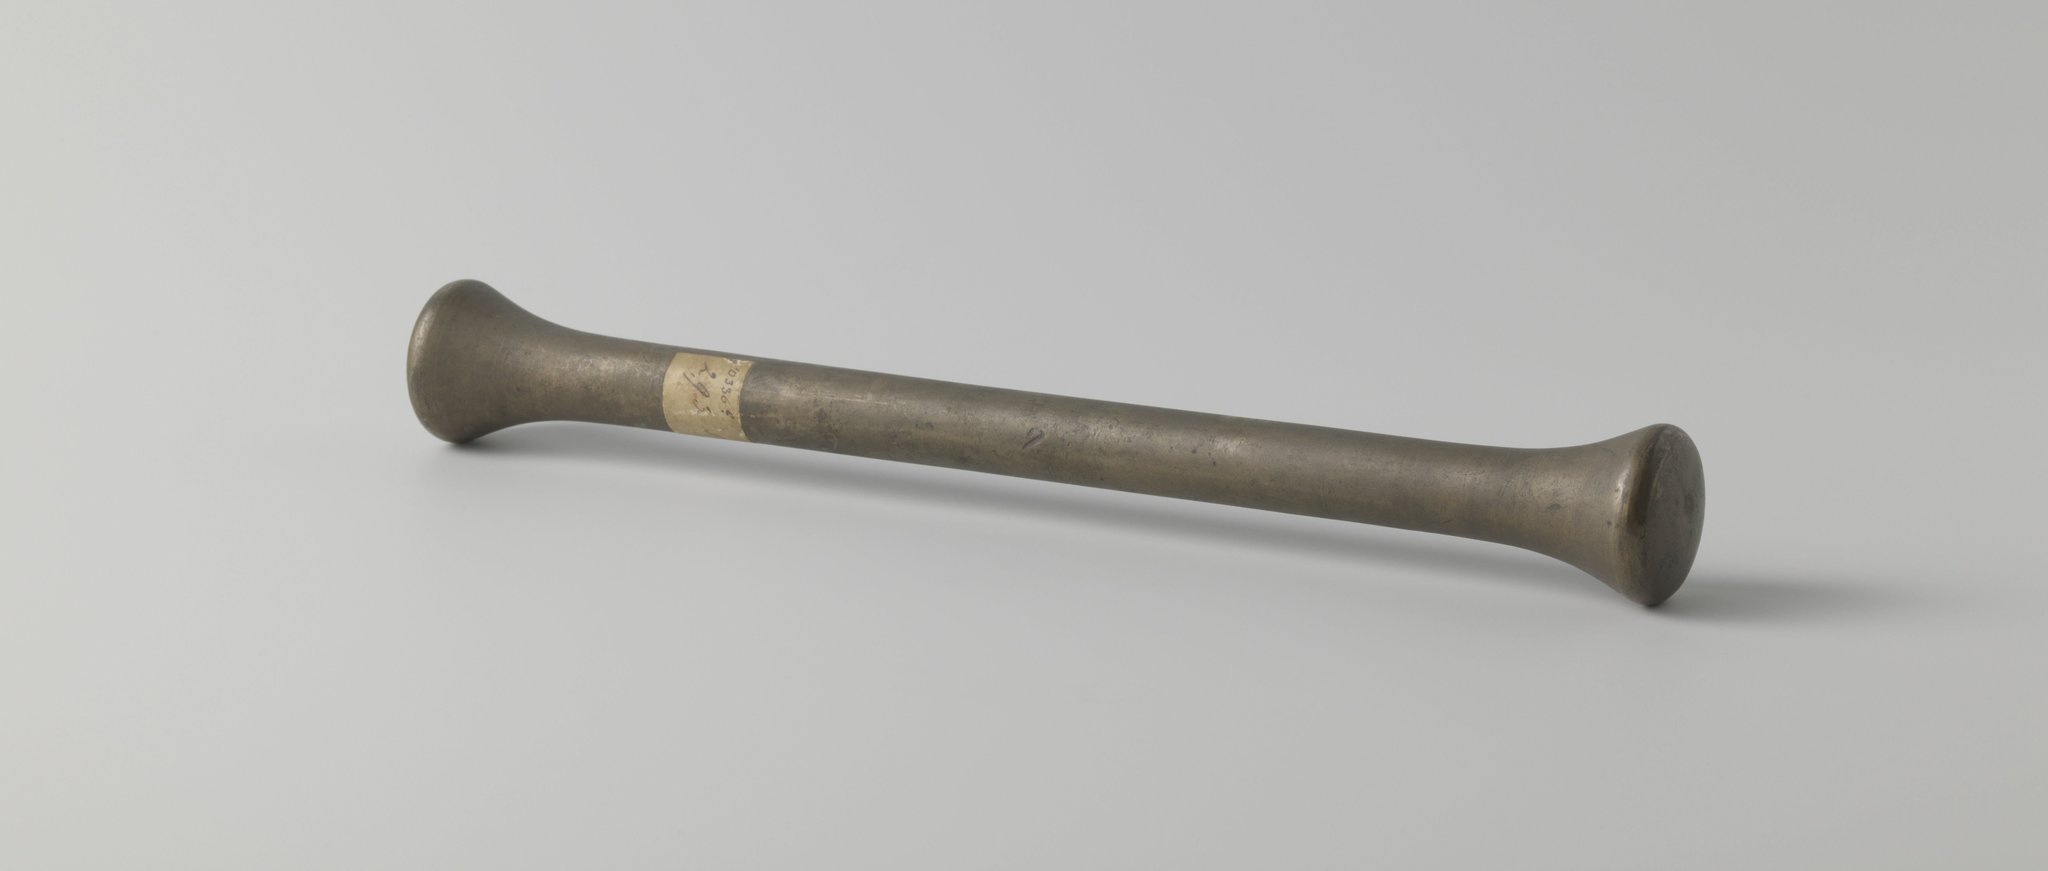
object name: beater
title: Stamper van brons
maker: Anonymous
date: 1700-1800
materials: bronze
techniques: casting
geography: netherlands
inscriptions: inscription: ‘2’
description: De stamper hoorde vermoedelijk niet bij de vijzel van Ter Horst, aangezien eenzelfde stamper (BK-NM-10335-B) ook te vinden is bij een vijzel van Walbroeck, die ruim een eeuw later is vervaardigd.